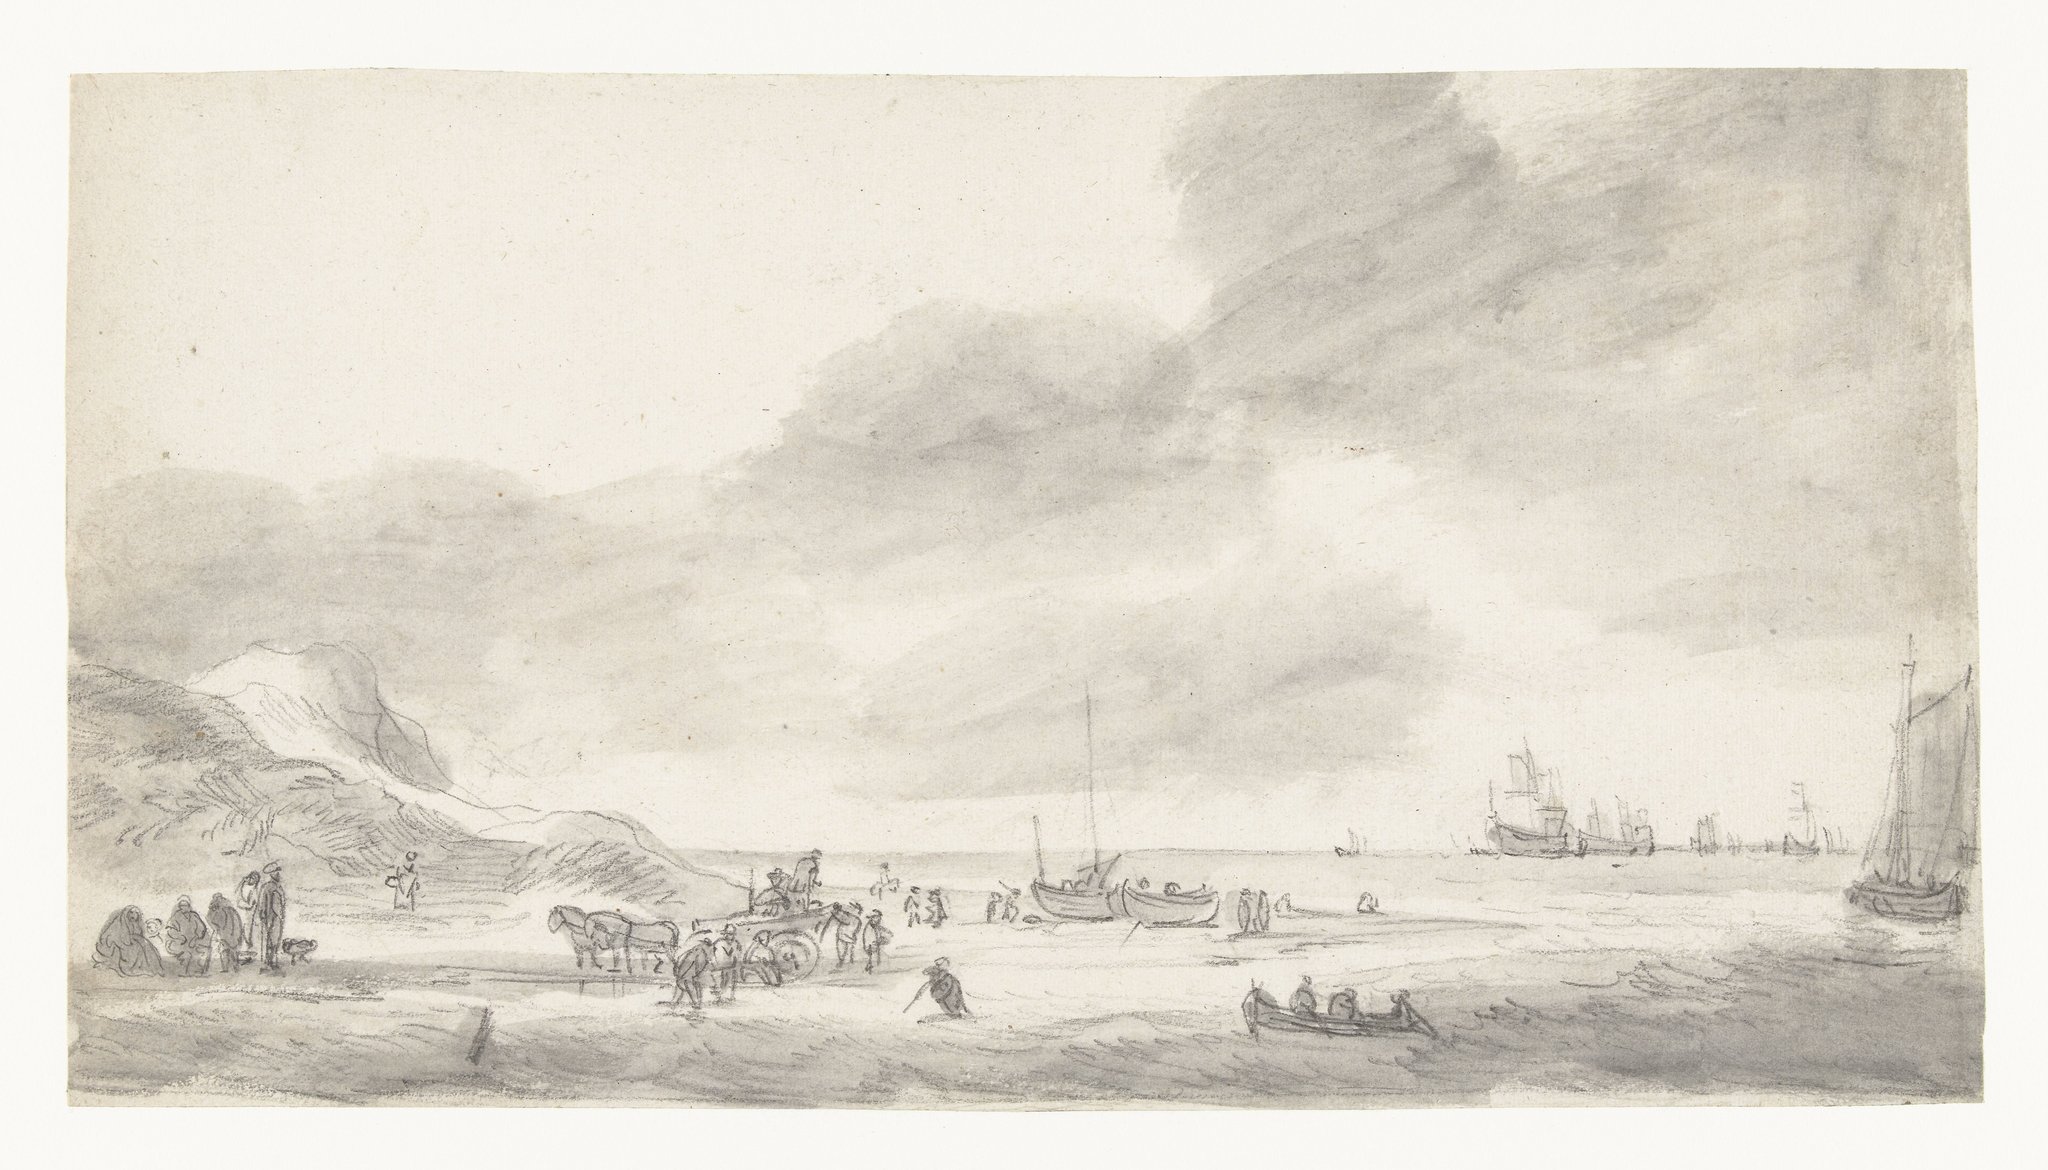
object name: drawing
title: Strandgezicht met schelpenvissers en wandelaars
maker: simon de vlieger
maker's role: draughtsman, painter, print maker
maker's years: 1600-1653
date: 1610-1653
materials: chalk, paper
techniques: brush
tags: beach